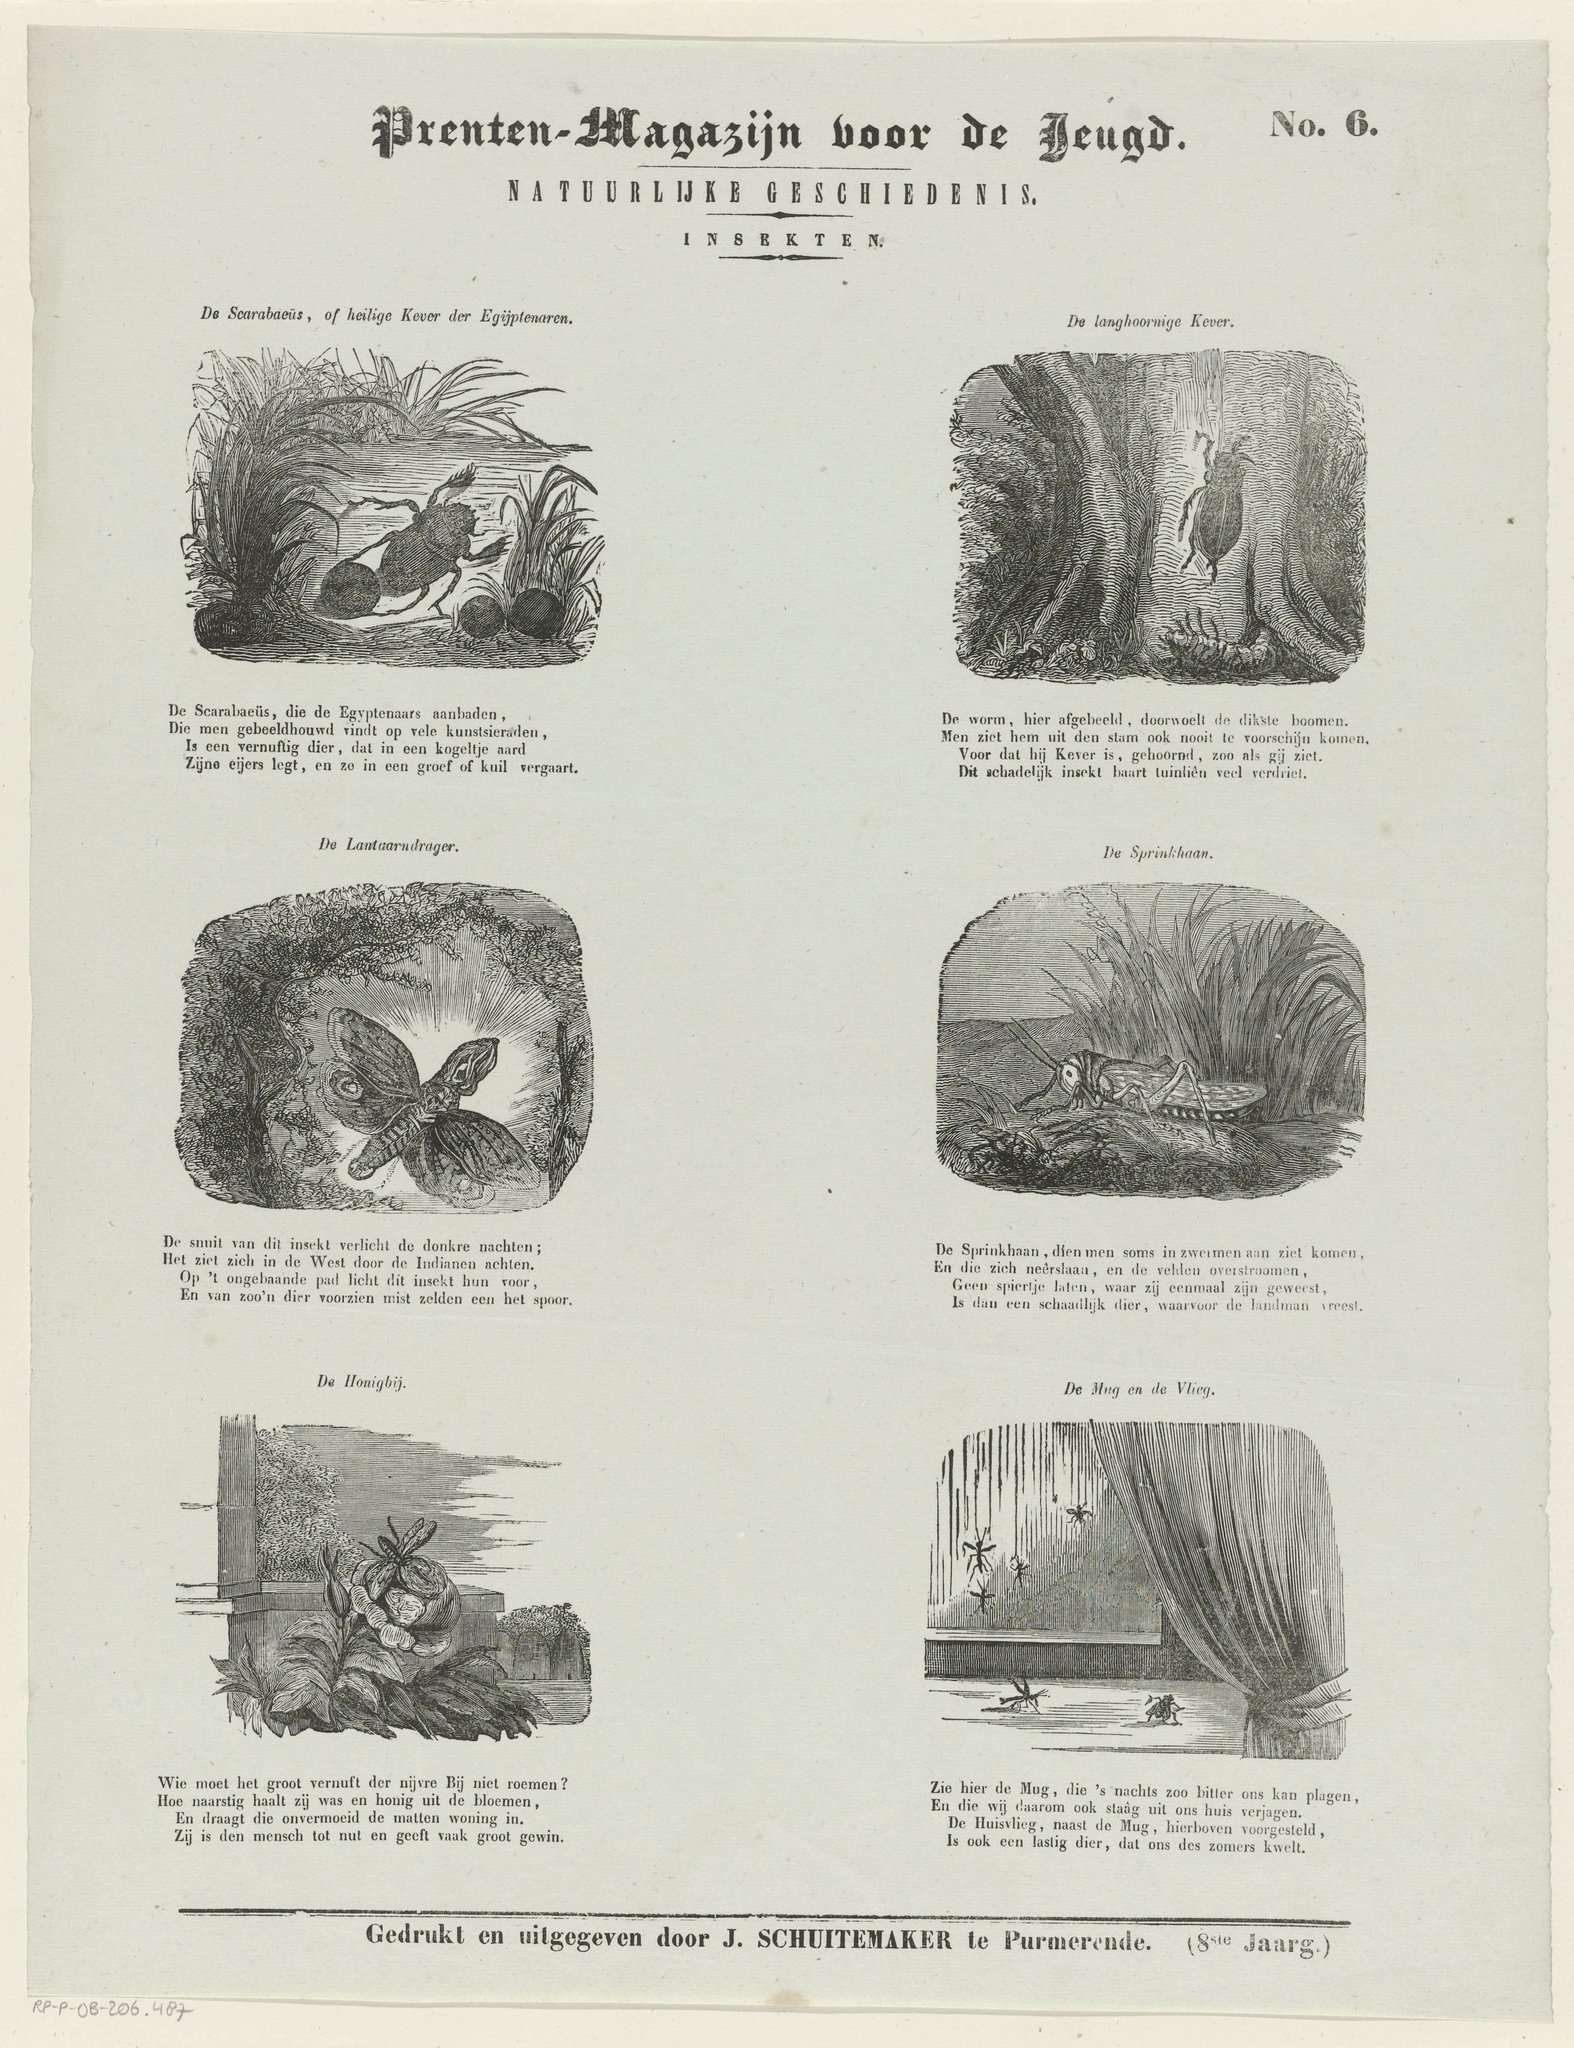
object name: popular print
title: Insekten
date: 1849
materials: paper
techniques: letterpress printing, engraving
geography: purmerend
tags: insects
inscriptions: collector's mark: Lugt 2760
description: Blad met 6 voorstellingen van insekten. Boven elke afbeelding een titel, onder elke afbeelding een vierregelig vers. Genummerd rechtsboven: No. 6.